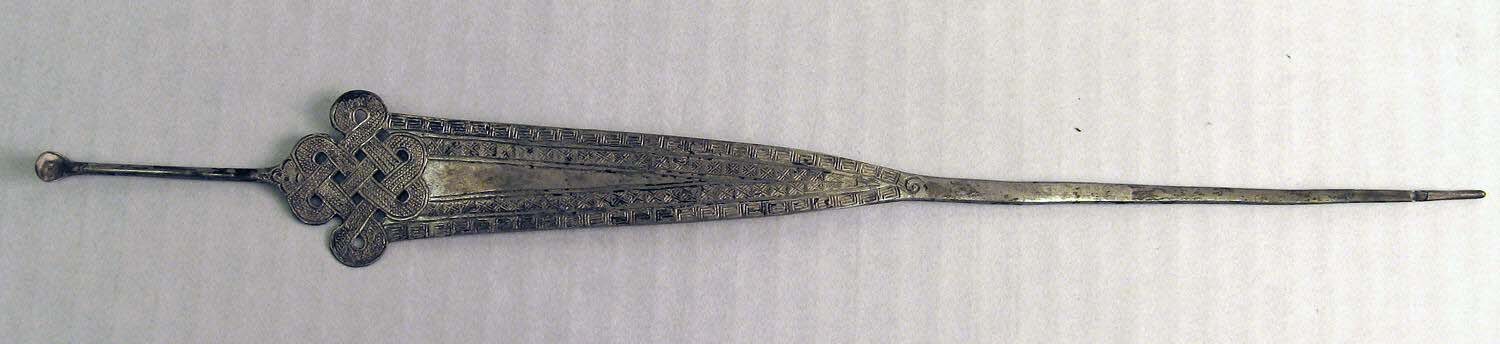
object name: hairpin and ear scraper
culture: chinese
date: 1368-1644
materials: silver